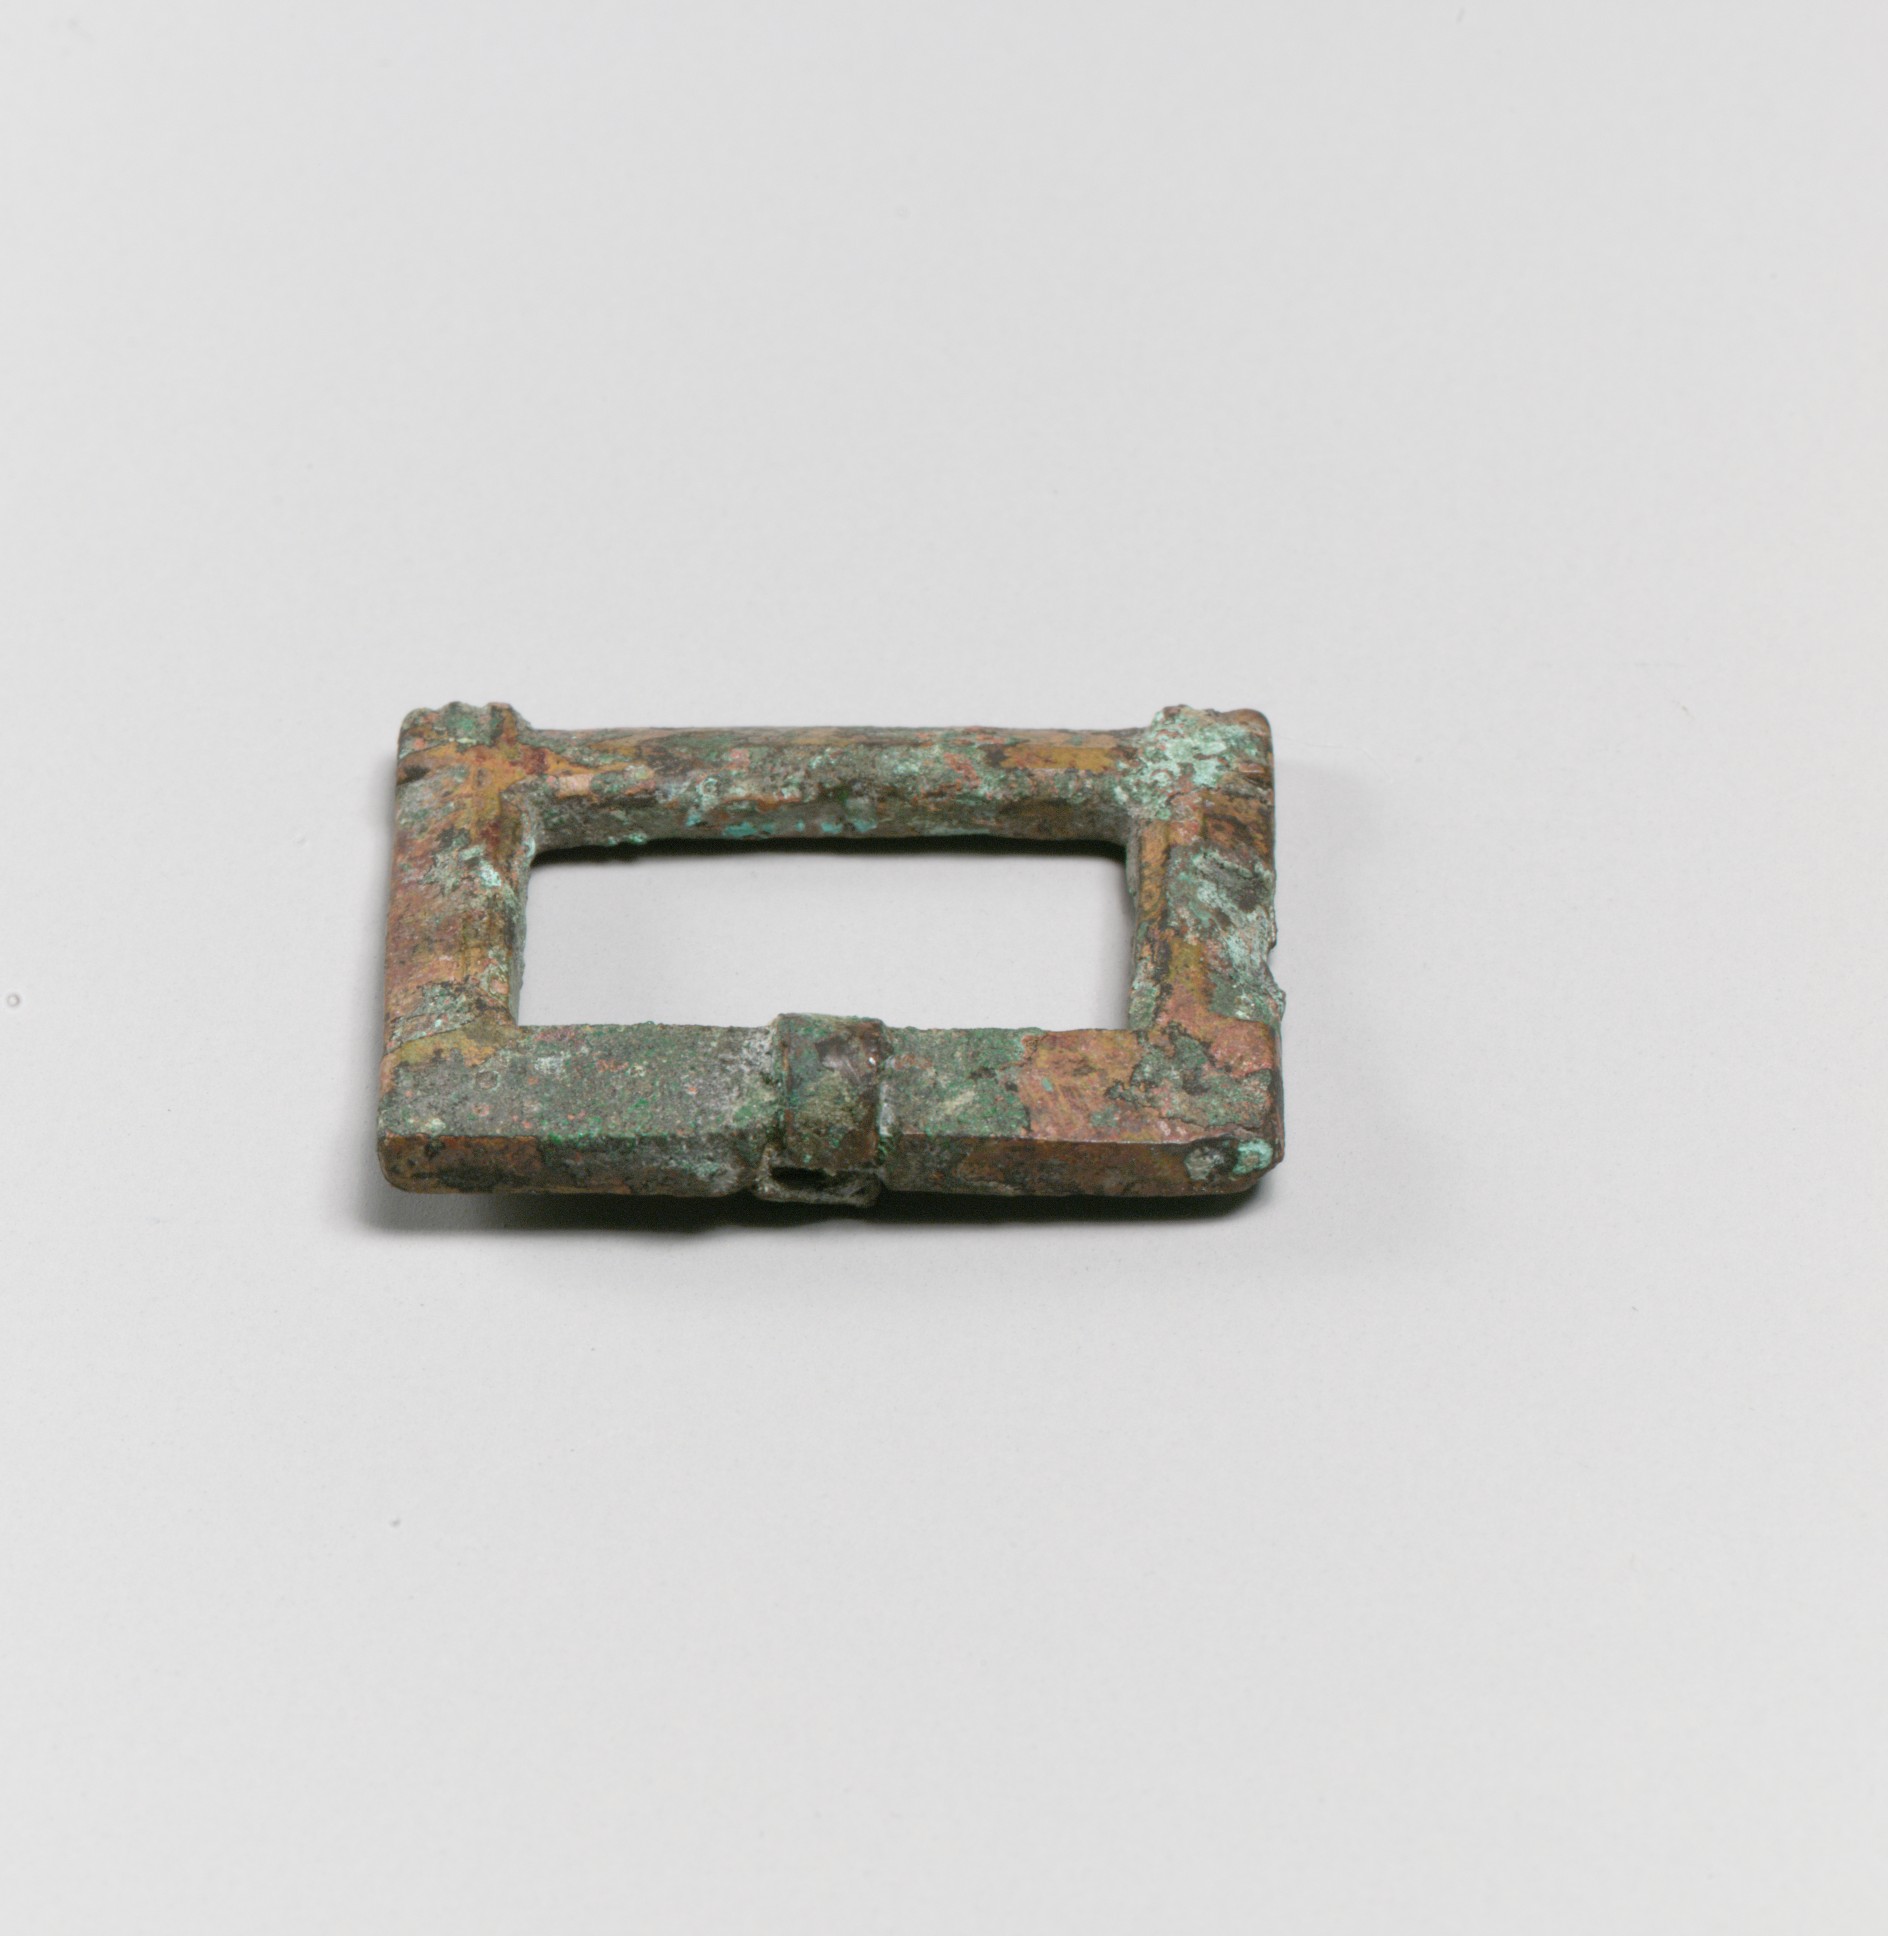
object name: buckle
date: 7000 BCE-330 CE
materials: bronze